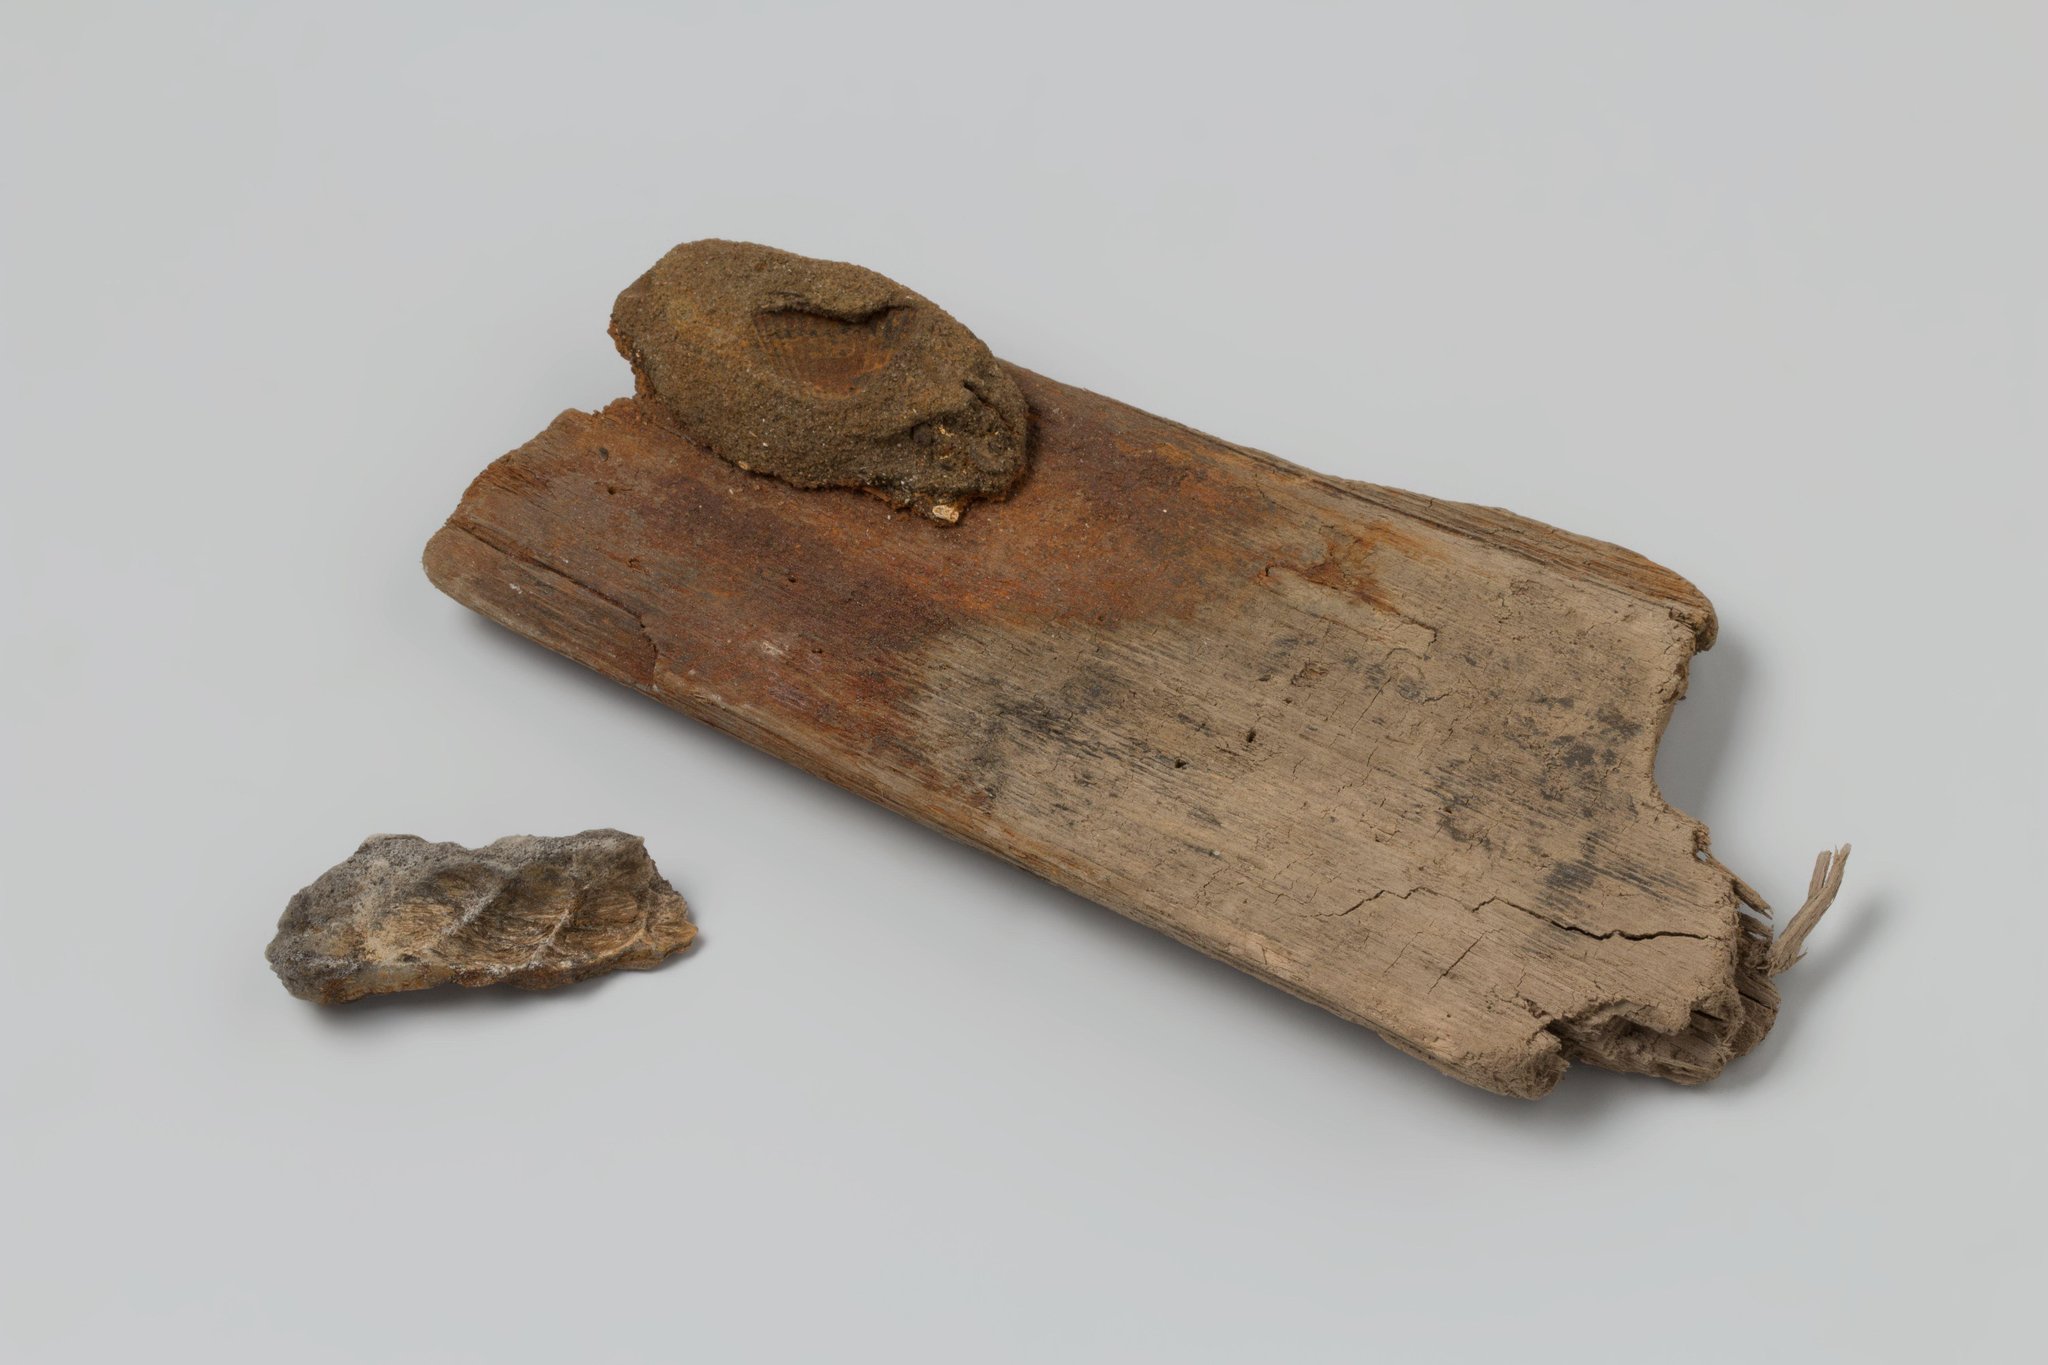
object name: plank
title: Fragment houten plank met concretie uit het wrak van de Oost-Indiëvaarder 't Vliegend Hart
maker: Anonymous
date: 1700-1735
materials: stone, wood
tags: 't vliegend hart (schip), verenigde oostindische compagnie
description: Fragment hout met concretie met de afdruk van een schelp zit en fragment met touwafdruk.